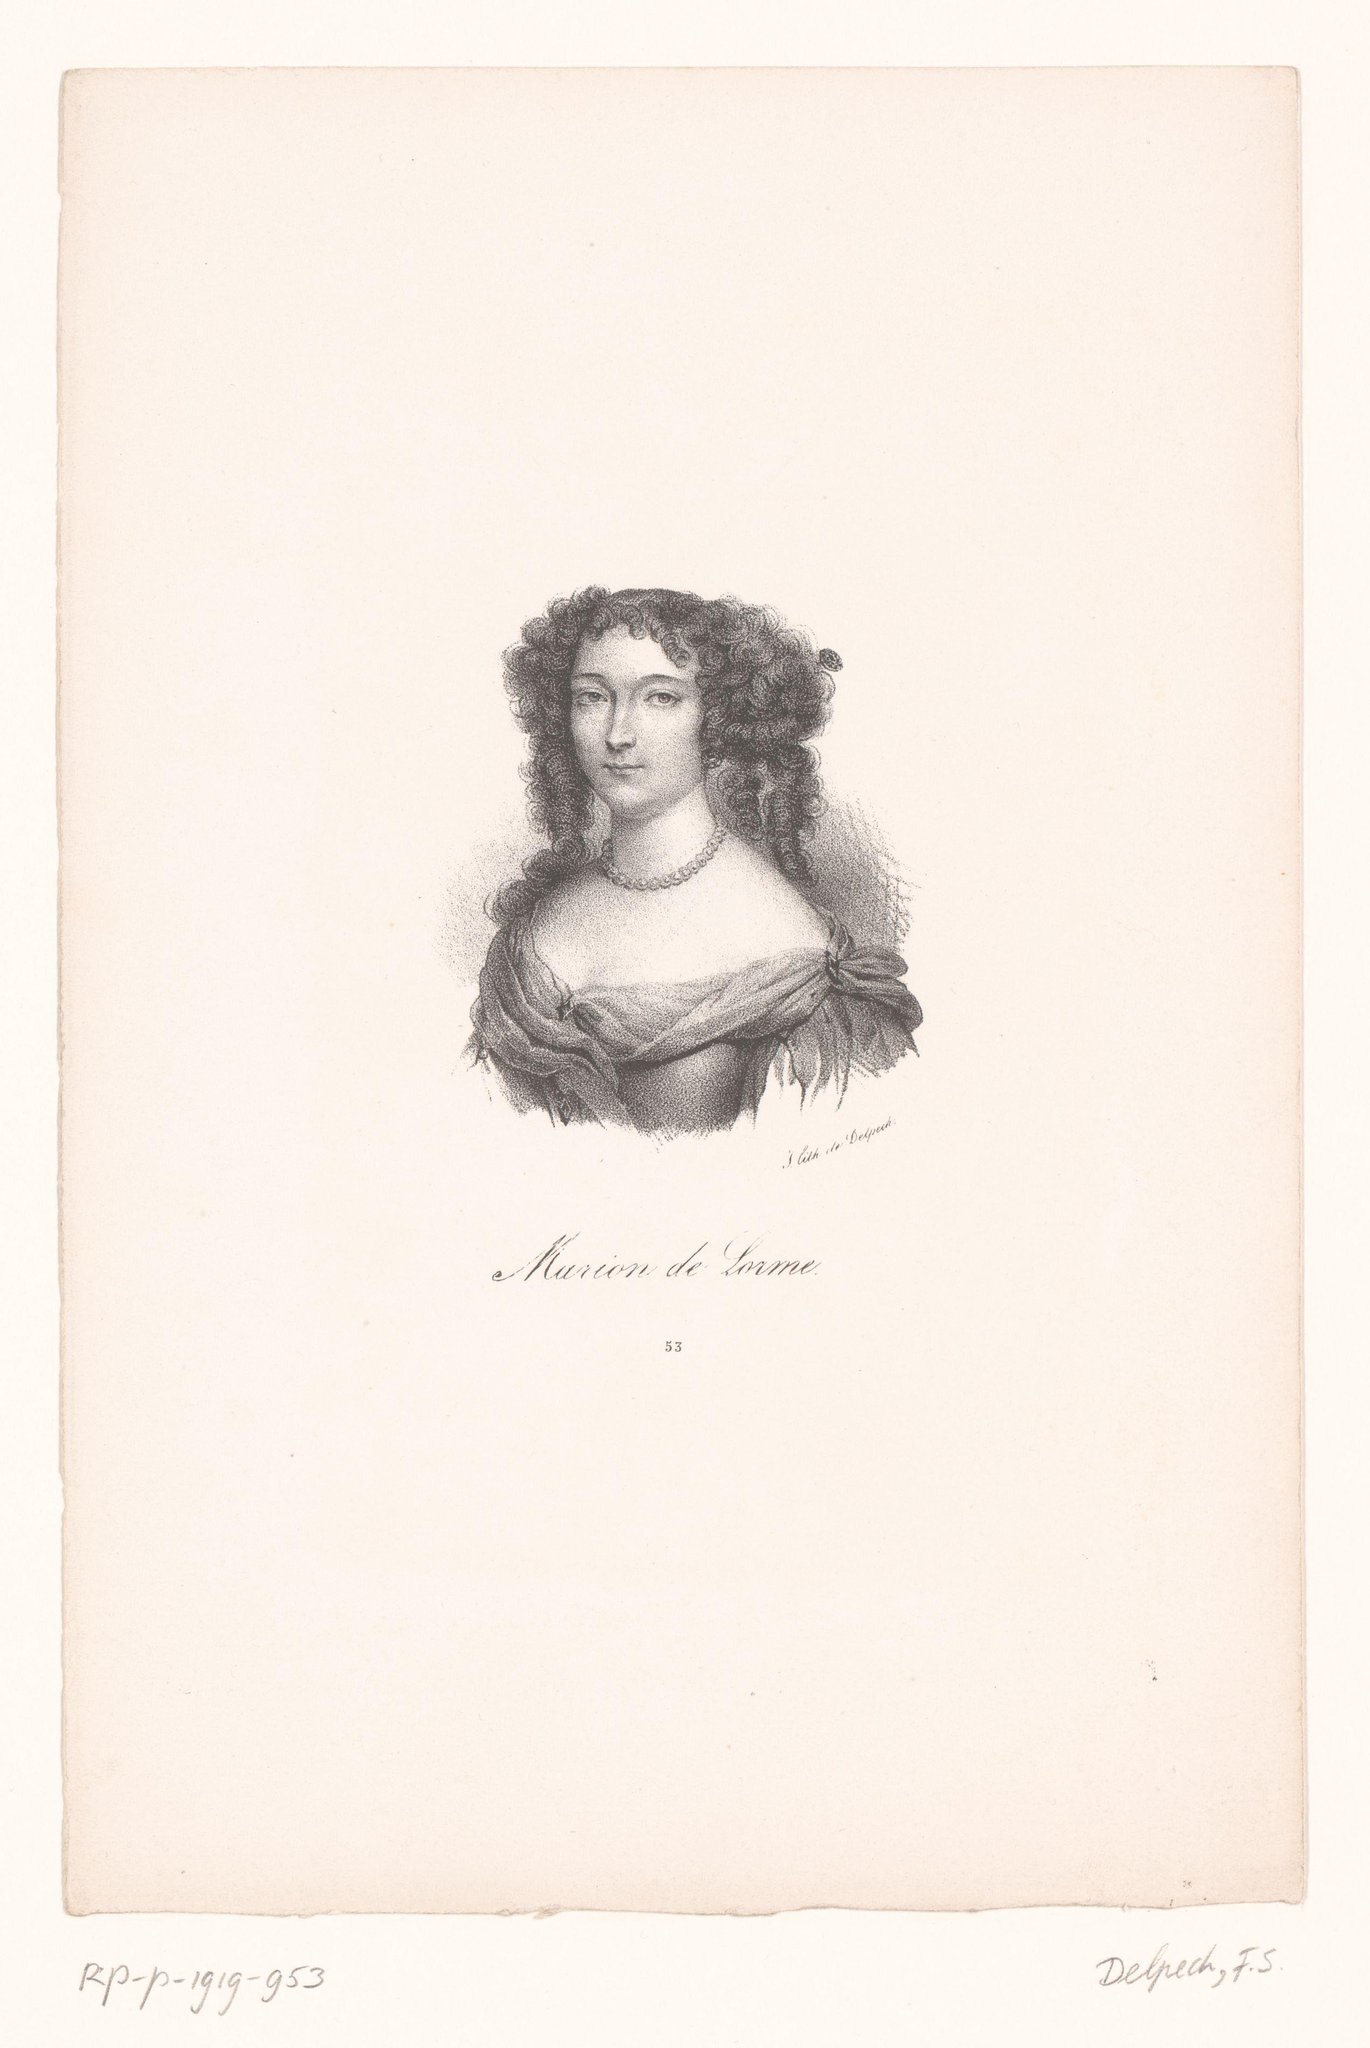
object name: print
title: Marion de Lorme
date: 1830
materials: paper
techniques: lithograph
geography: paris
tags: paris, historical persons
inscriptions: collector's mark: Lugt 2228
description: Prent waarschijnlijk uit: Iconographie française ou recueil des portraits des personnages les plus illustres qui ont paru en France depuis François premier jusqu'à la fin du règne de Louis XVI (…). Aflevering XIV. Parijs: veuve Delpech, 1830. Mogelijk komt de prent ook voor in eerdere en/of latere publicaties uitgegeven door veuve Delpech of haar opvolger Rosselin.